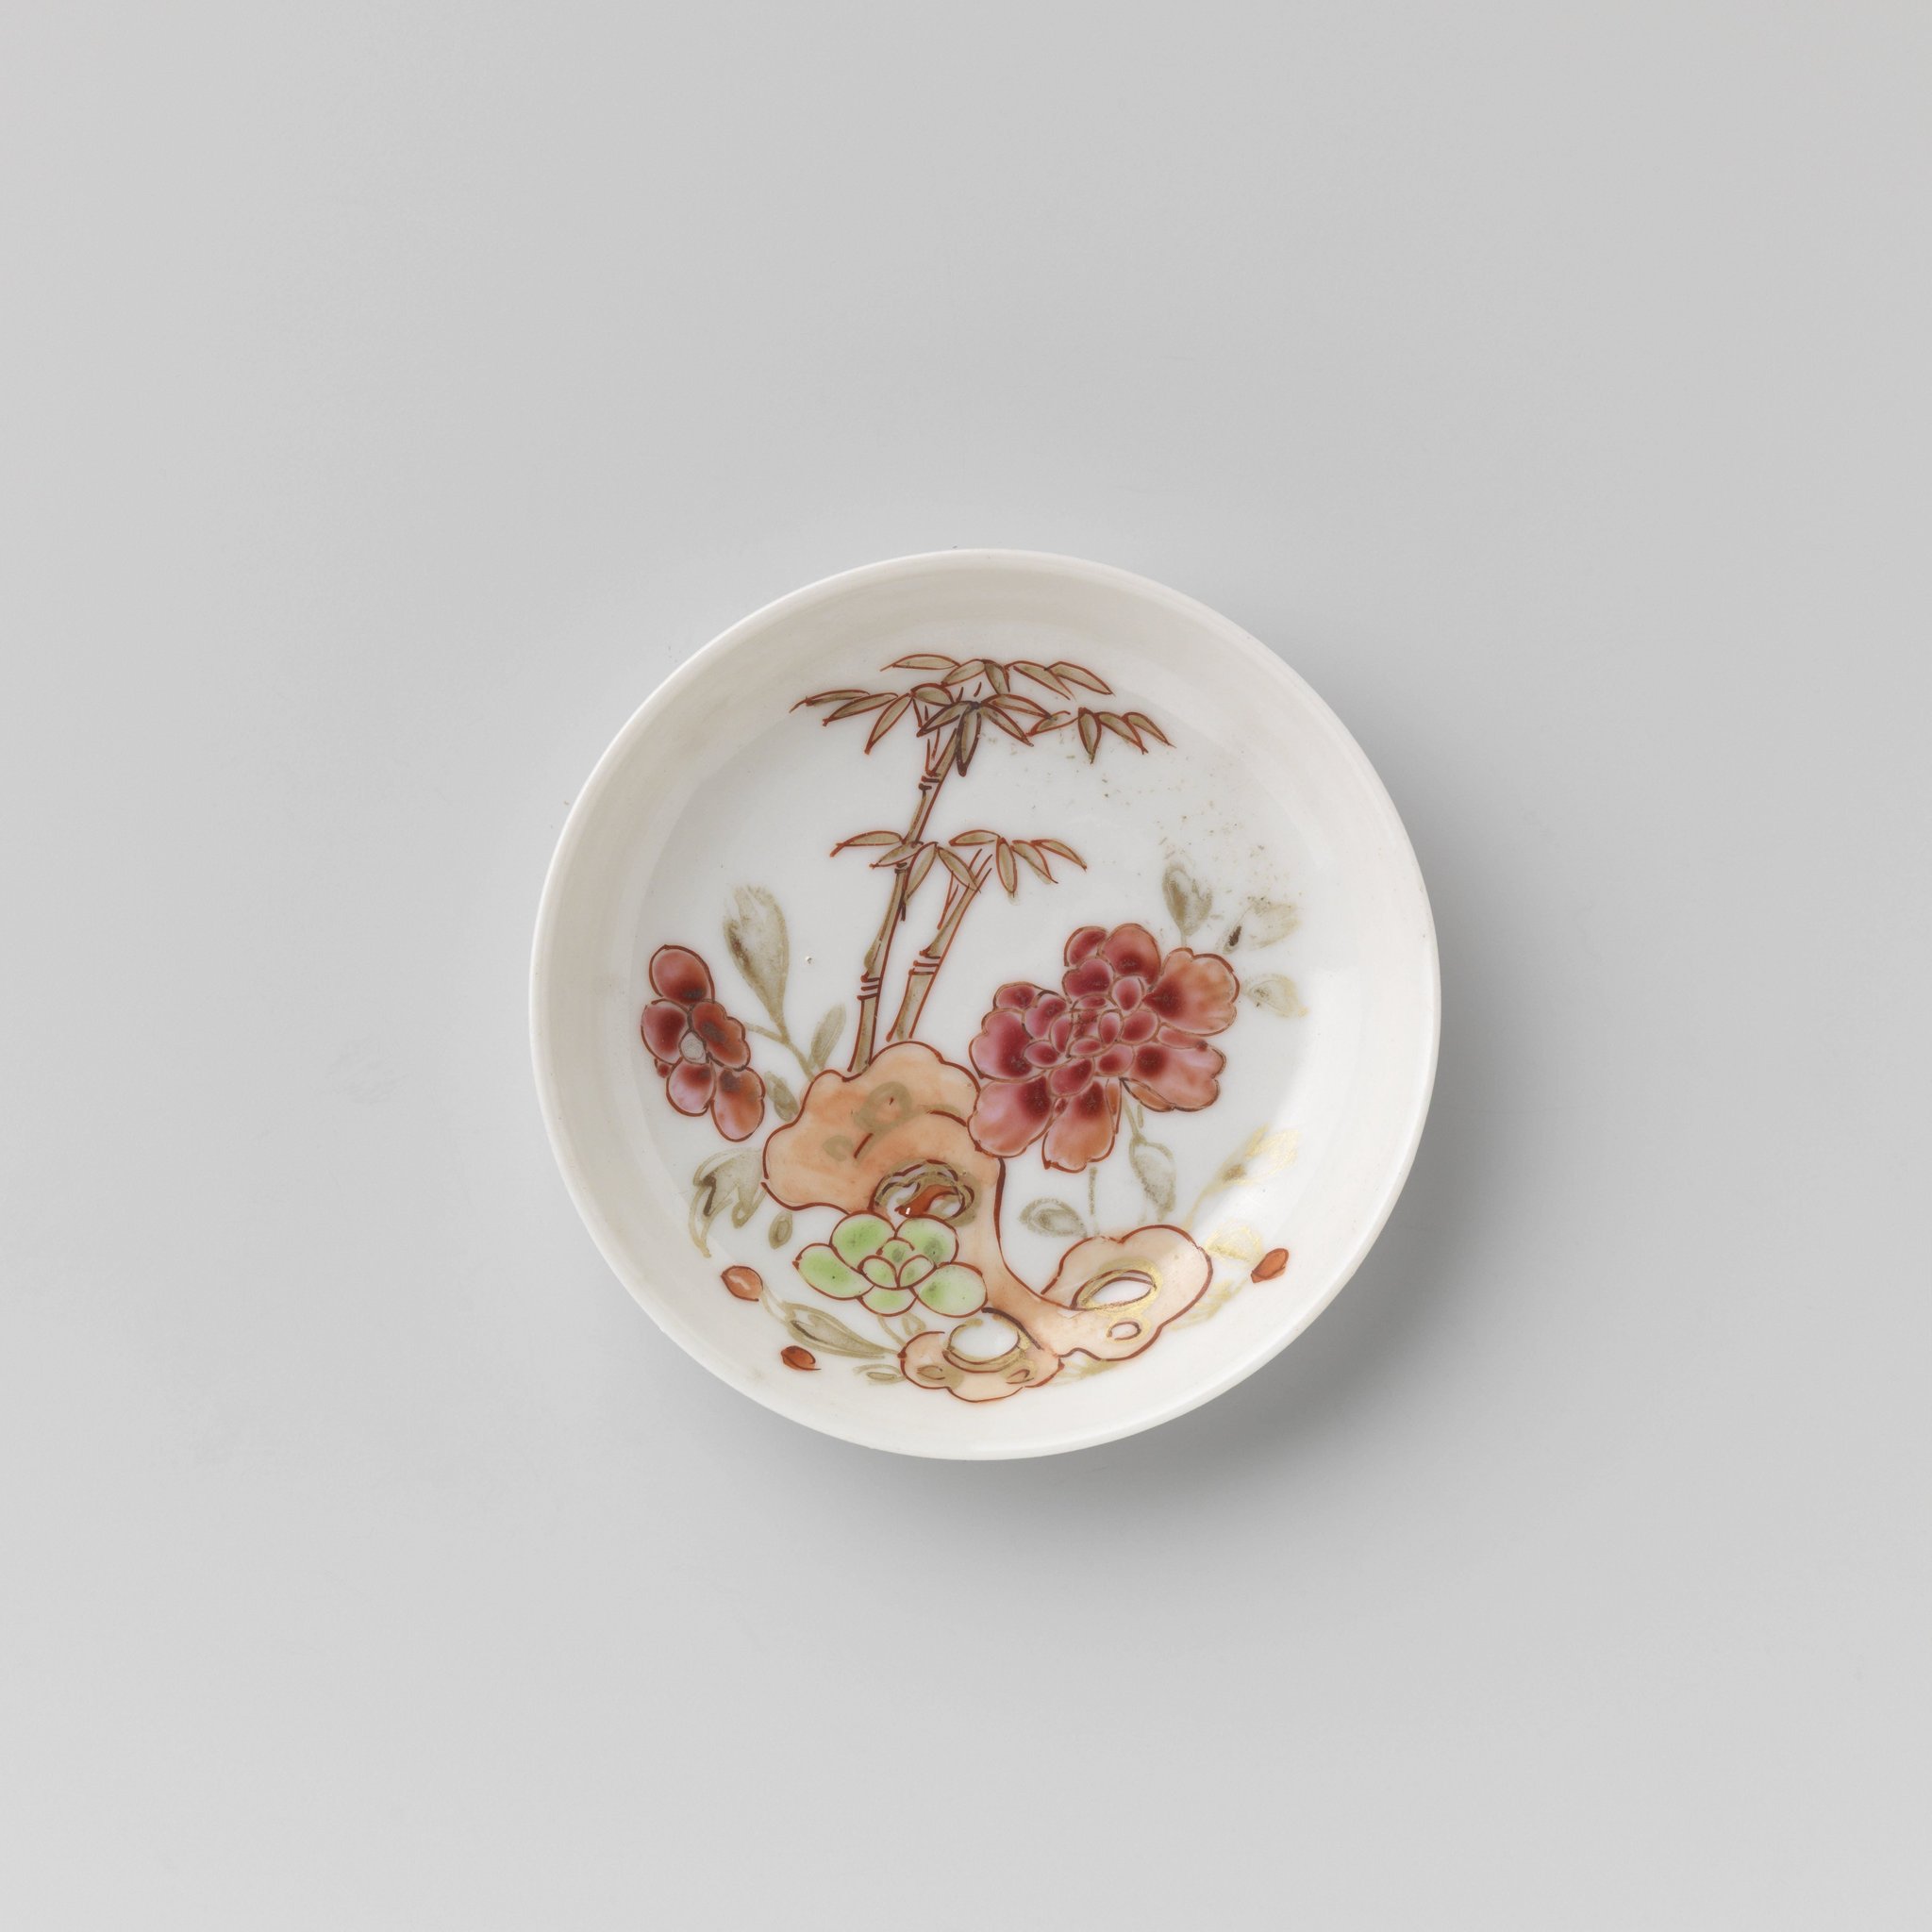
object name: platter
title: saucer with rock, peony and bamboo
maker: Anonymous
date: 1725-1749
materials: glaze, gold, paint, porcelain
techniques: firing, gilding, turning, vitrification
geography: china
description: Schotel van porselein, beschilderd op het glazuur in rood, roze, groen en goud. Op het plat van de schotel een rots met pioen en bamboe. Famille rose.